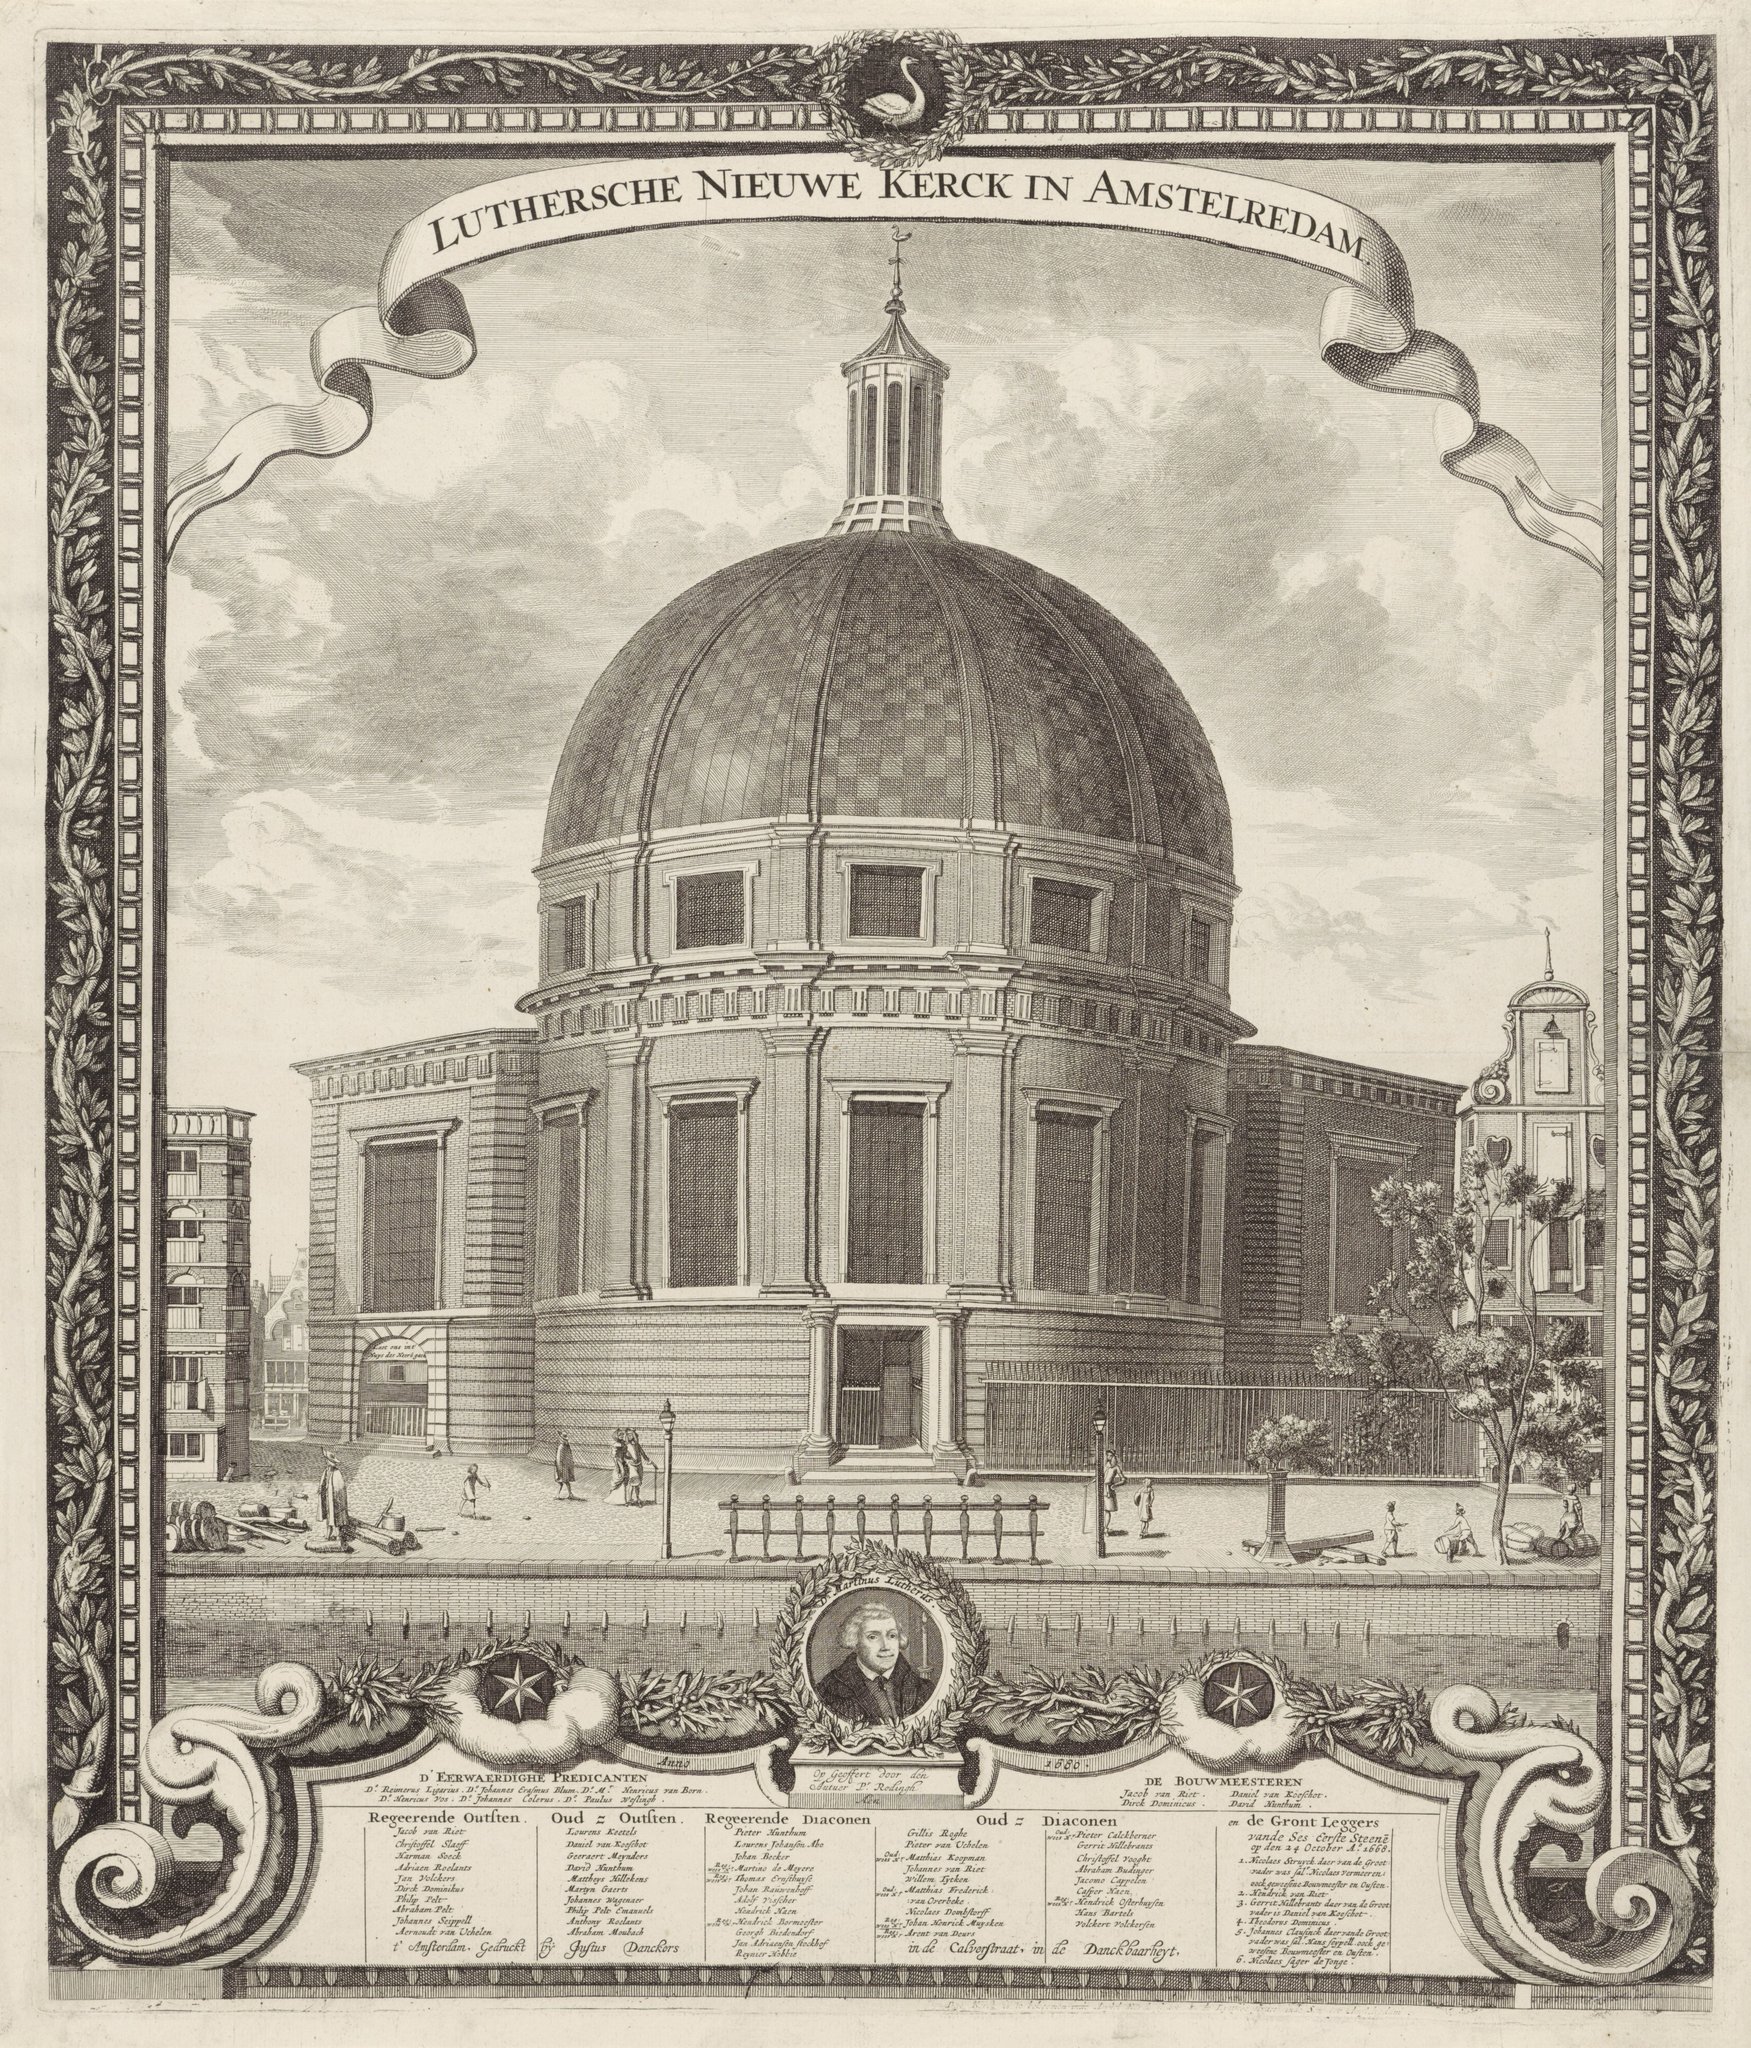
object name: print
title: Luthersche Nieuwe Kerck in Amstelredam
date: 1680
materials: paper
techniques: engraving, etching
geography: amsterdam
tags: priest, martin luther, church (exterior), canals, waters (in city), street (+ city(-scape) with figures, staffage)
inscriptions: collector's mark: Lugt 2760, collector's mark: Lugt 2228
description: Gezicht op de Ronde Lutherse Kerk, ook wel bekend als de Nieuwe Lutherse Kerk of de Koepelkerk, aan de Singel te Amsterdam. Gezien vanaf de overkant van het water. Op straat voor de kerk een aantal figuren. Boven in het midden een zwaan als luthers symbool. Daaronder een banderol met de titel. Onder een cartouche met een portret van Martin Luther en de namen van (en opdracht aan) belangrijke personen van deze kerk (predikanten, zittende ouderlingen, voormalige ouderlingen, zittende diakenen, voormalige diakenen, bouwmeesters en leggers van de eerste zes stenen).